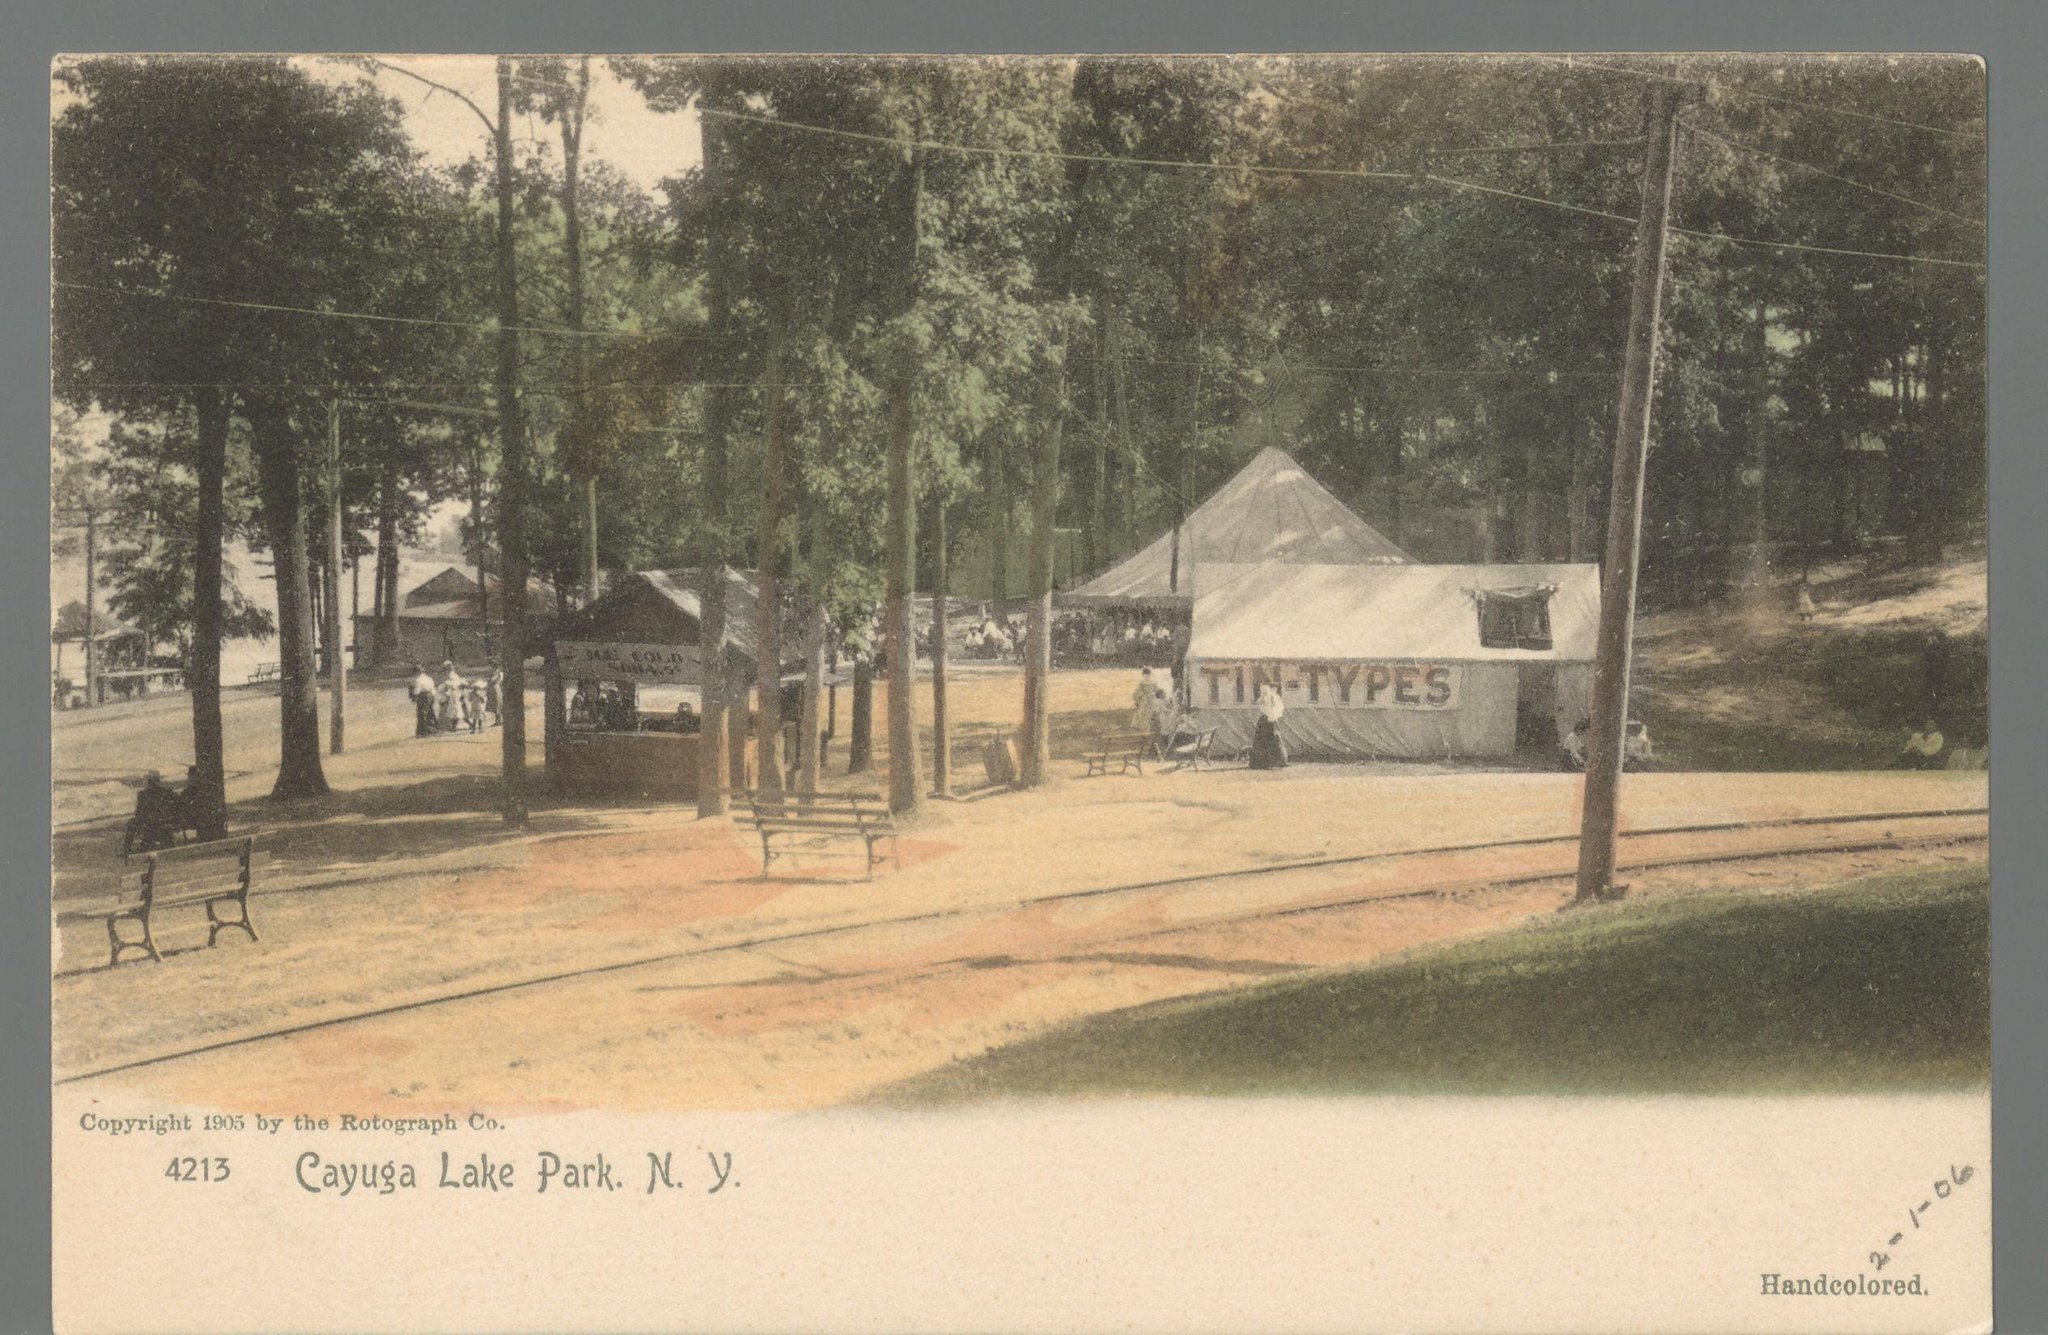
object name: photomechanical print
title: Cayuga Lake Park. N.Y.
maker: Anonymous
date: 1905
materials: cardboard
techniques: photograph, hand coloring, writing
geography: new york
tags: park, studio ~ photographer - cc - out of doors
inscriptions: date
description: Ferrotypie-tent bij Cayuga Lake Park, New York, Verenigde Staten.